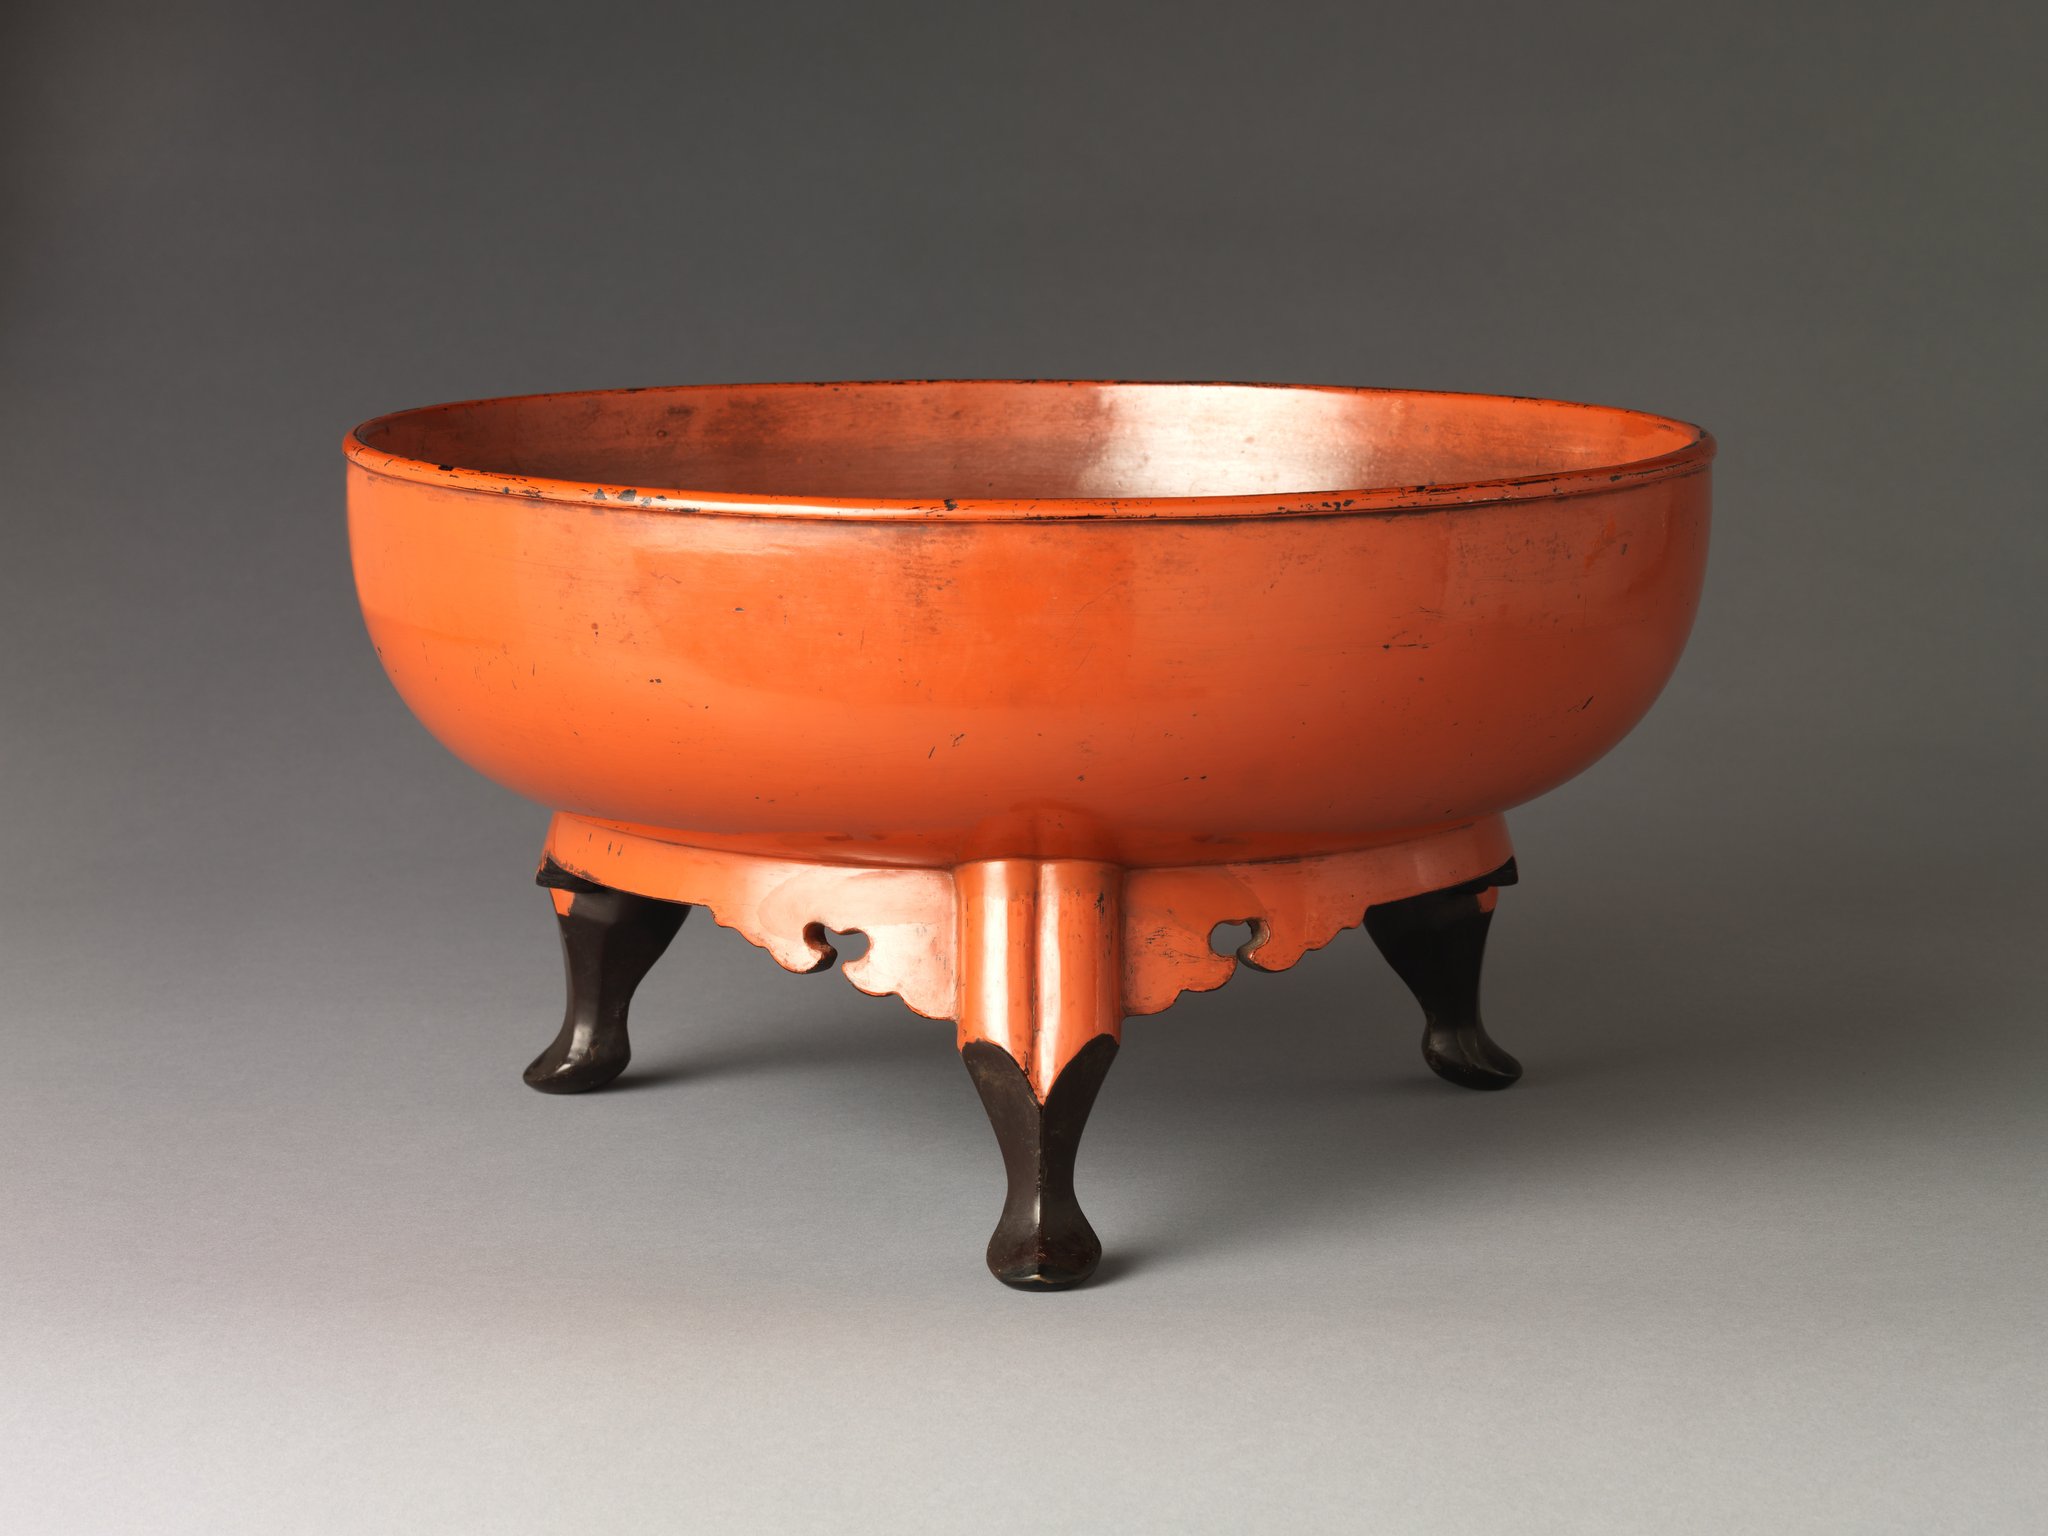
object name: bowl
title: Bowl with Three Scalloped Feet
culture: japanese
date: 1501-1600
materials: lacquer